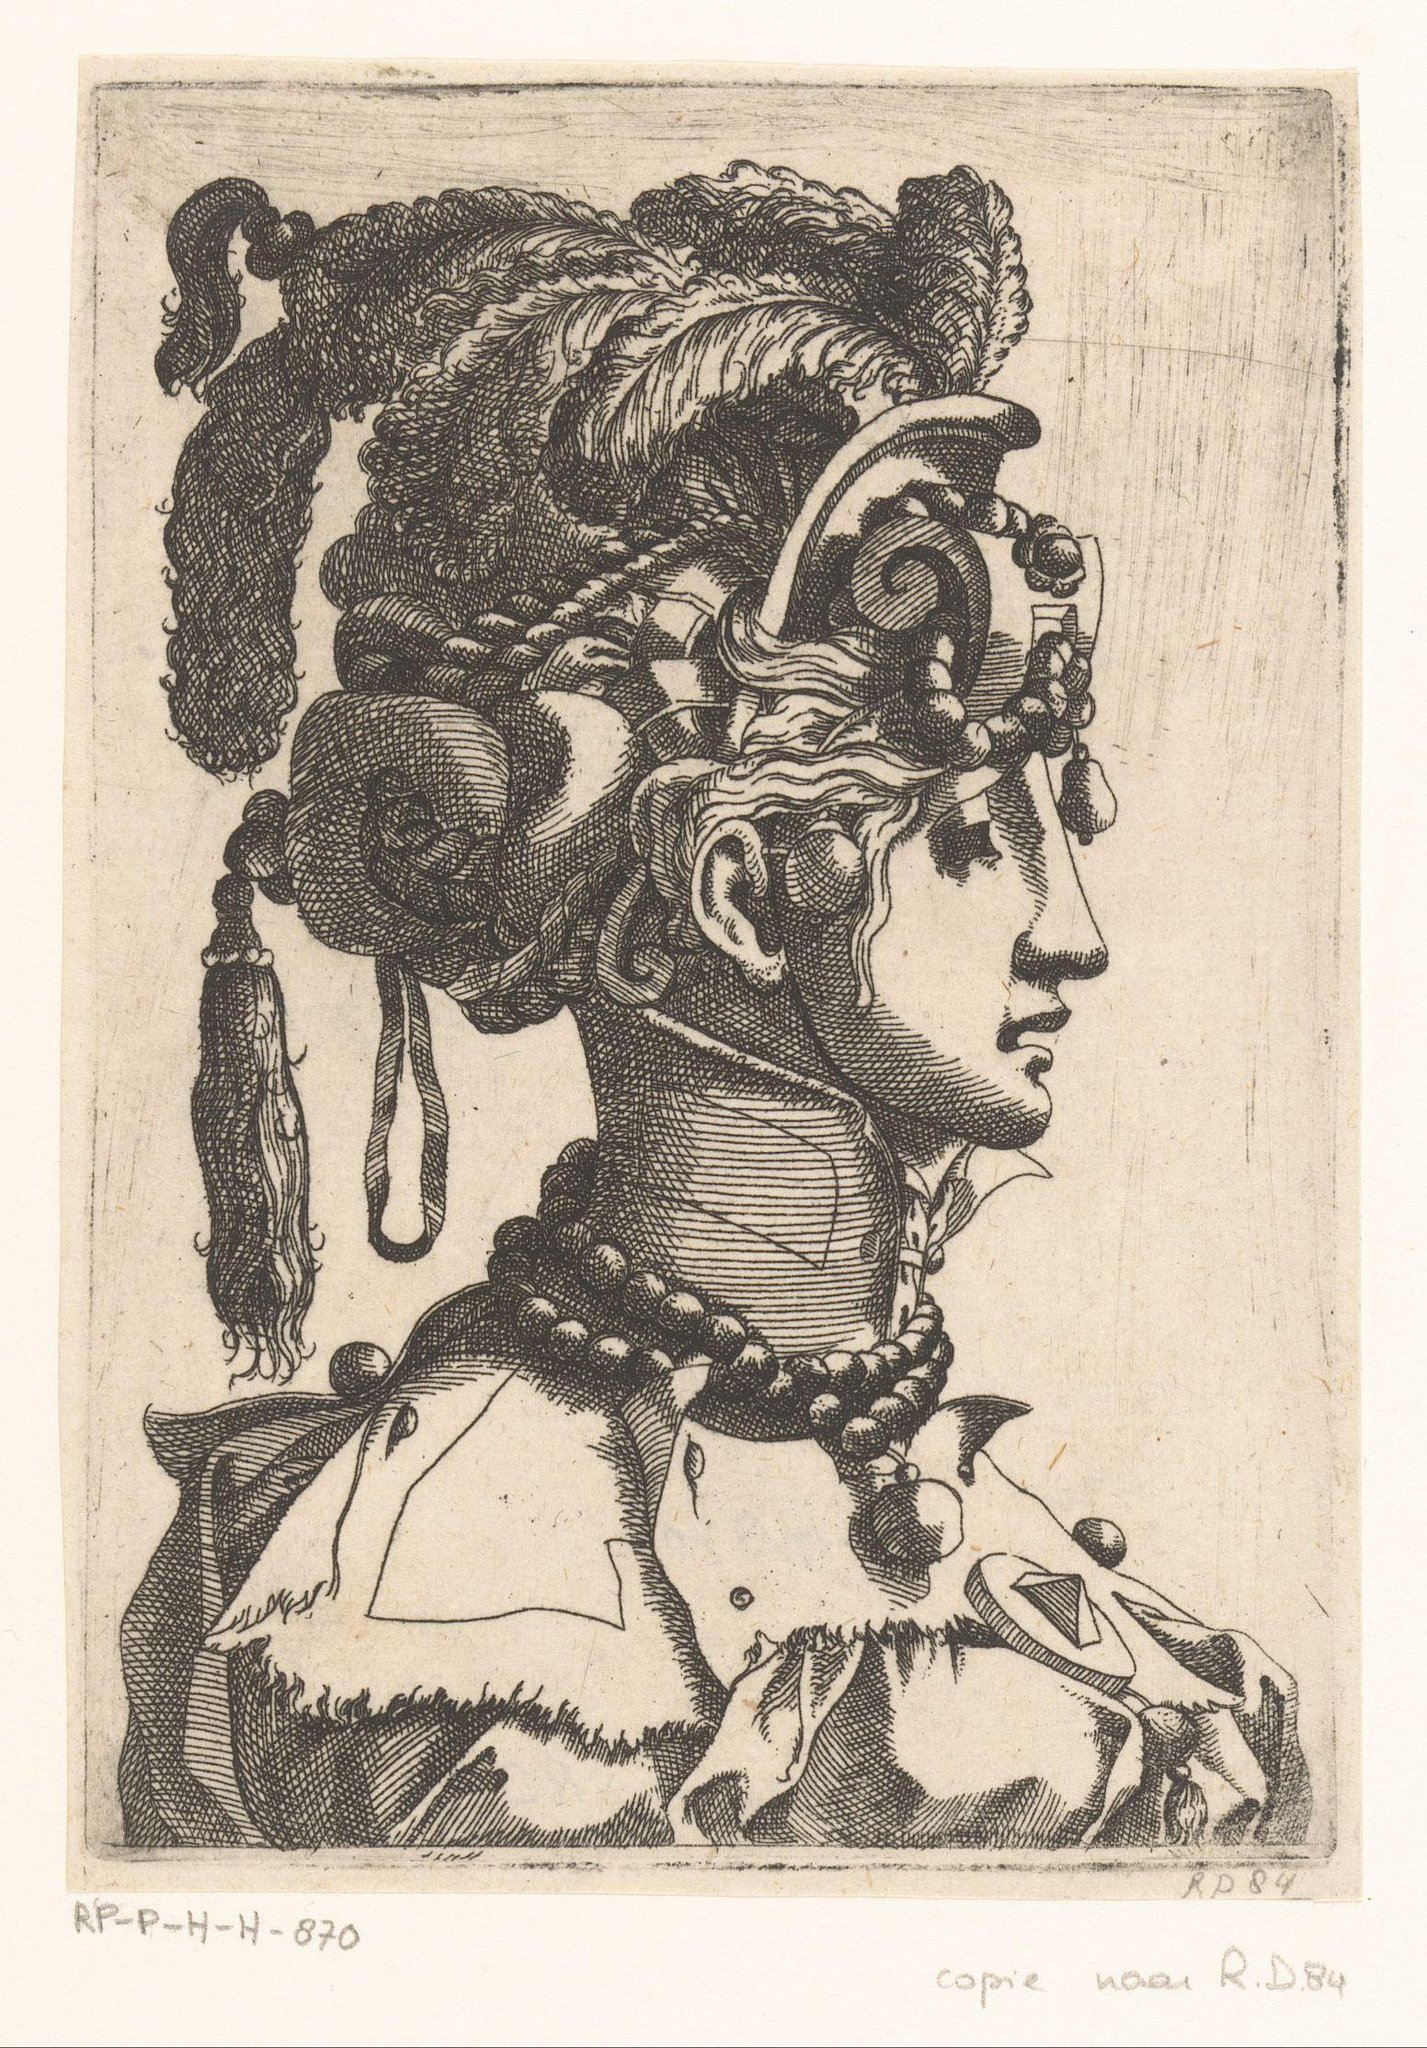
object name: print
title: Vrouw met masker en fantasie hoofdbedekking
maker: Anonymous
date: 1535-1598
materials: paper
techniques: etching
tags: mask, head-gear, the arts of the stage: ballet, theatre, musical drama, motion picture, fantasy costume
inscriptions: collector's mark: Lugt 11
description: Kopie naar een prent uit een serie van twaalf prenten met mannen- en vrouwenkostuums en haardrachten voor het ballet, getiteld 'Coiffures ou masques d'hommes et de femmes pour des ballets', naar ontwerp door Rosso Fiorentino. Betreft een spiegelbeeldige kopie van de rechterkant van Dumesnil 84.